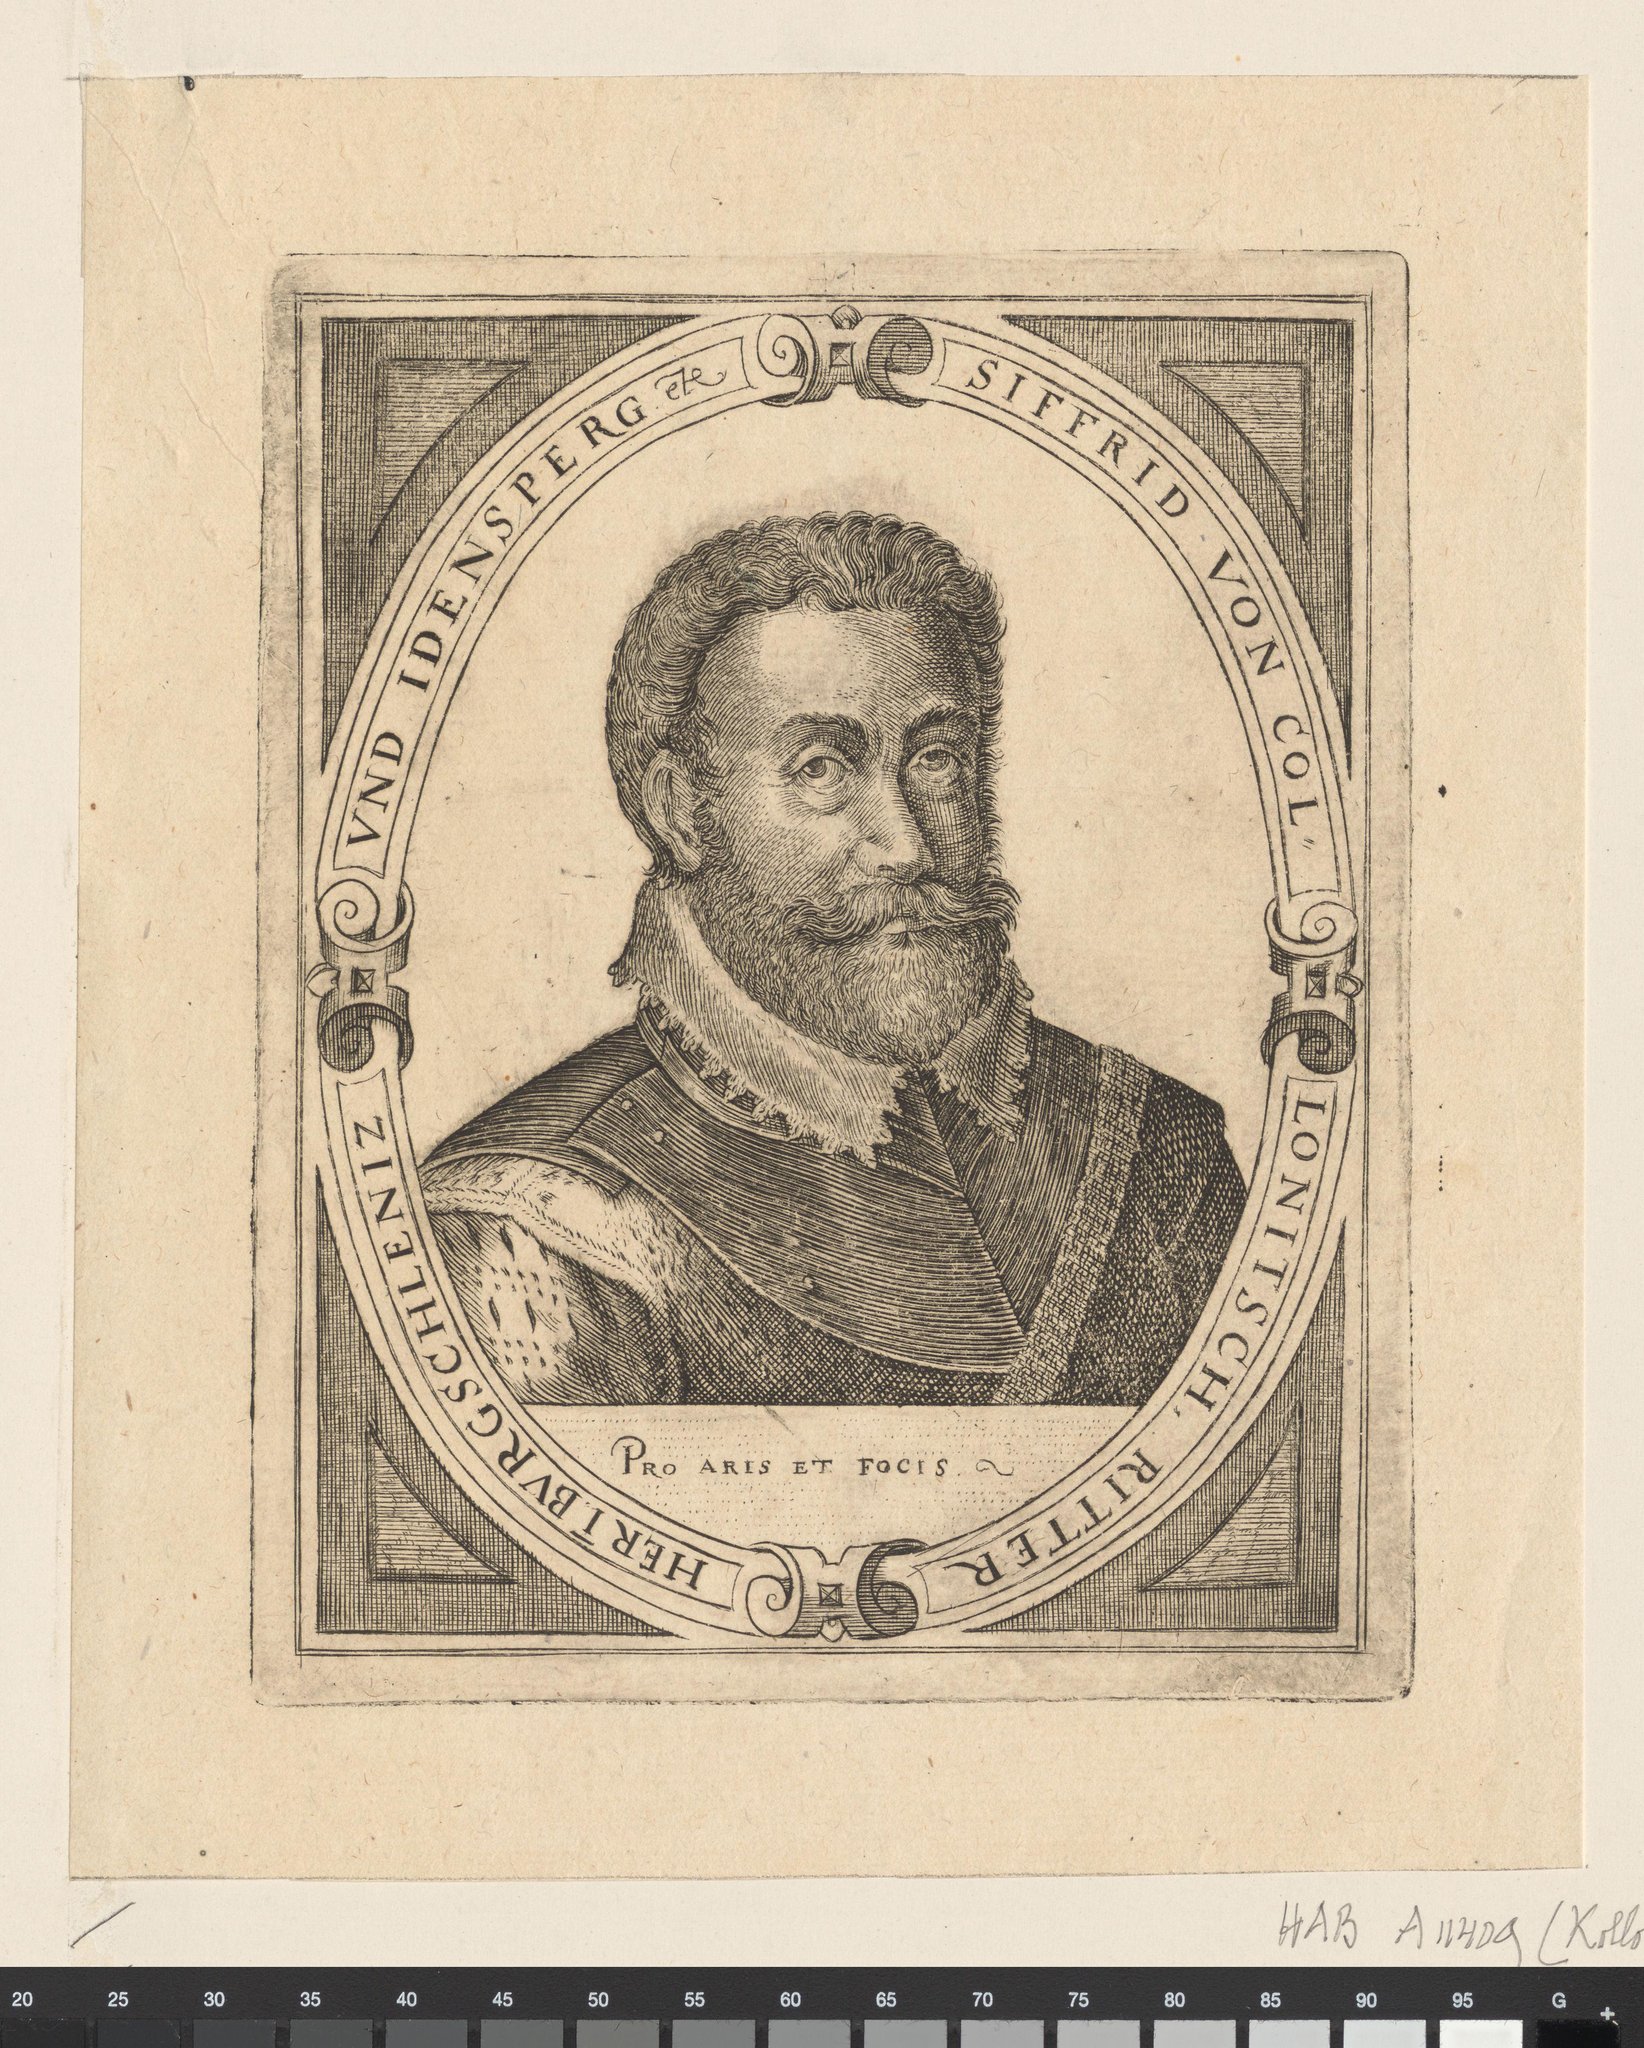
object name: print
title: Portret van Siegfried, baron van Kollonitsch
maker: hans sibmacher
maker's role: print maker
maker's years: -1611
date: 1603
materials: paper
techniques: engraving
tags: commander-in-chief, general, marshal, historical persons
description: Prent waarschijnlijk uit: Ortrelius, Hieronymus. Chronologia Oder Historische beschreibung aller Kriegsempörungen (...). Neurenberg: Johann Sibmacher, 1603. Een latere staat van de prent is ook gebruikt in: Meyer, Martin. Ortelius redivivus et continuatus, Oder Der Ungarischen Kriegs-Empörungen Historische Beschreibung. Neurenberg: Paul Fürst, 1665.